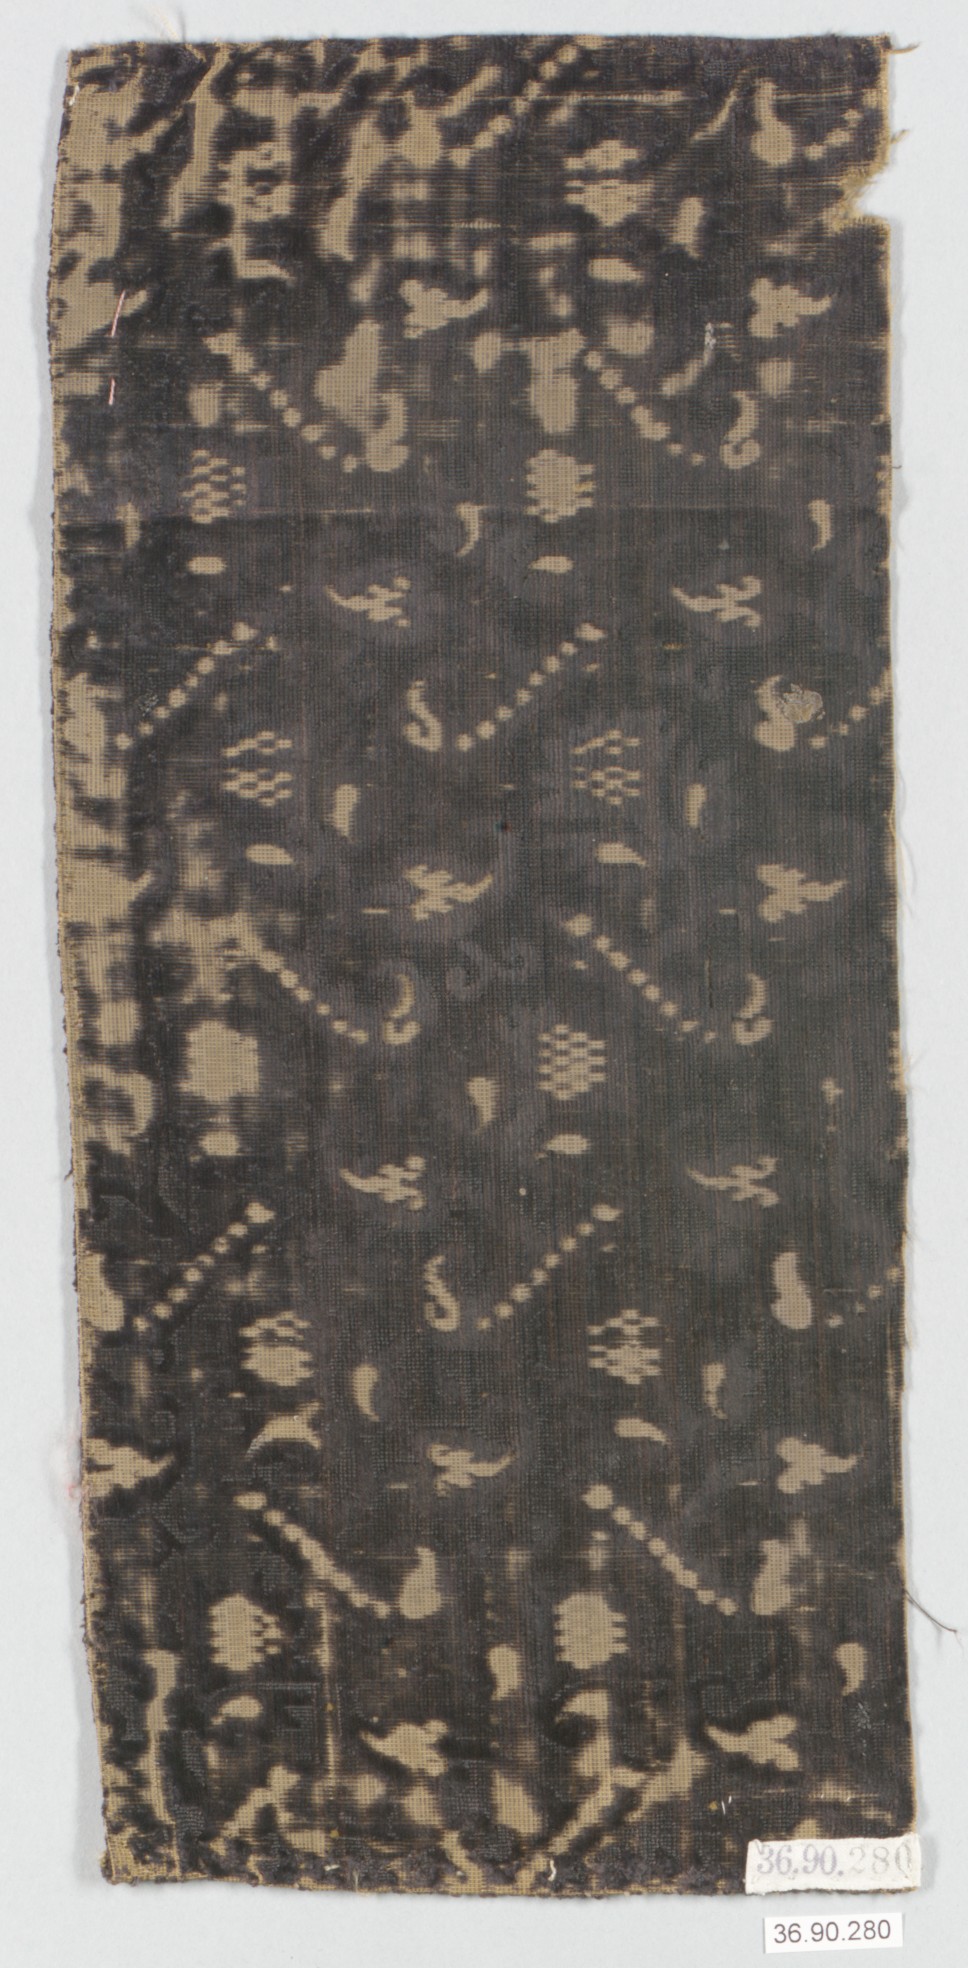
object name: piece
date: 1501-1700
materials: silk